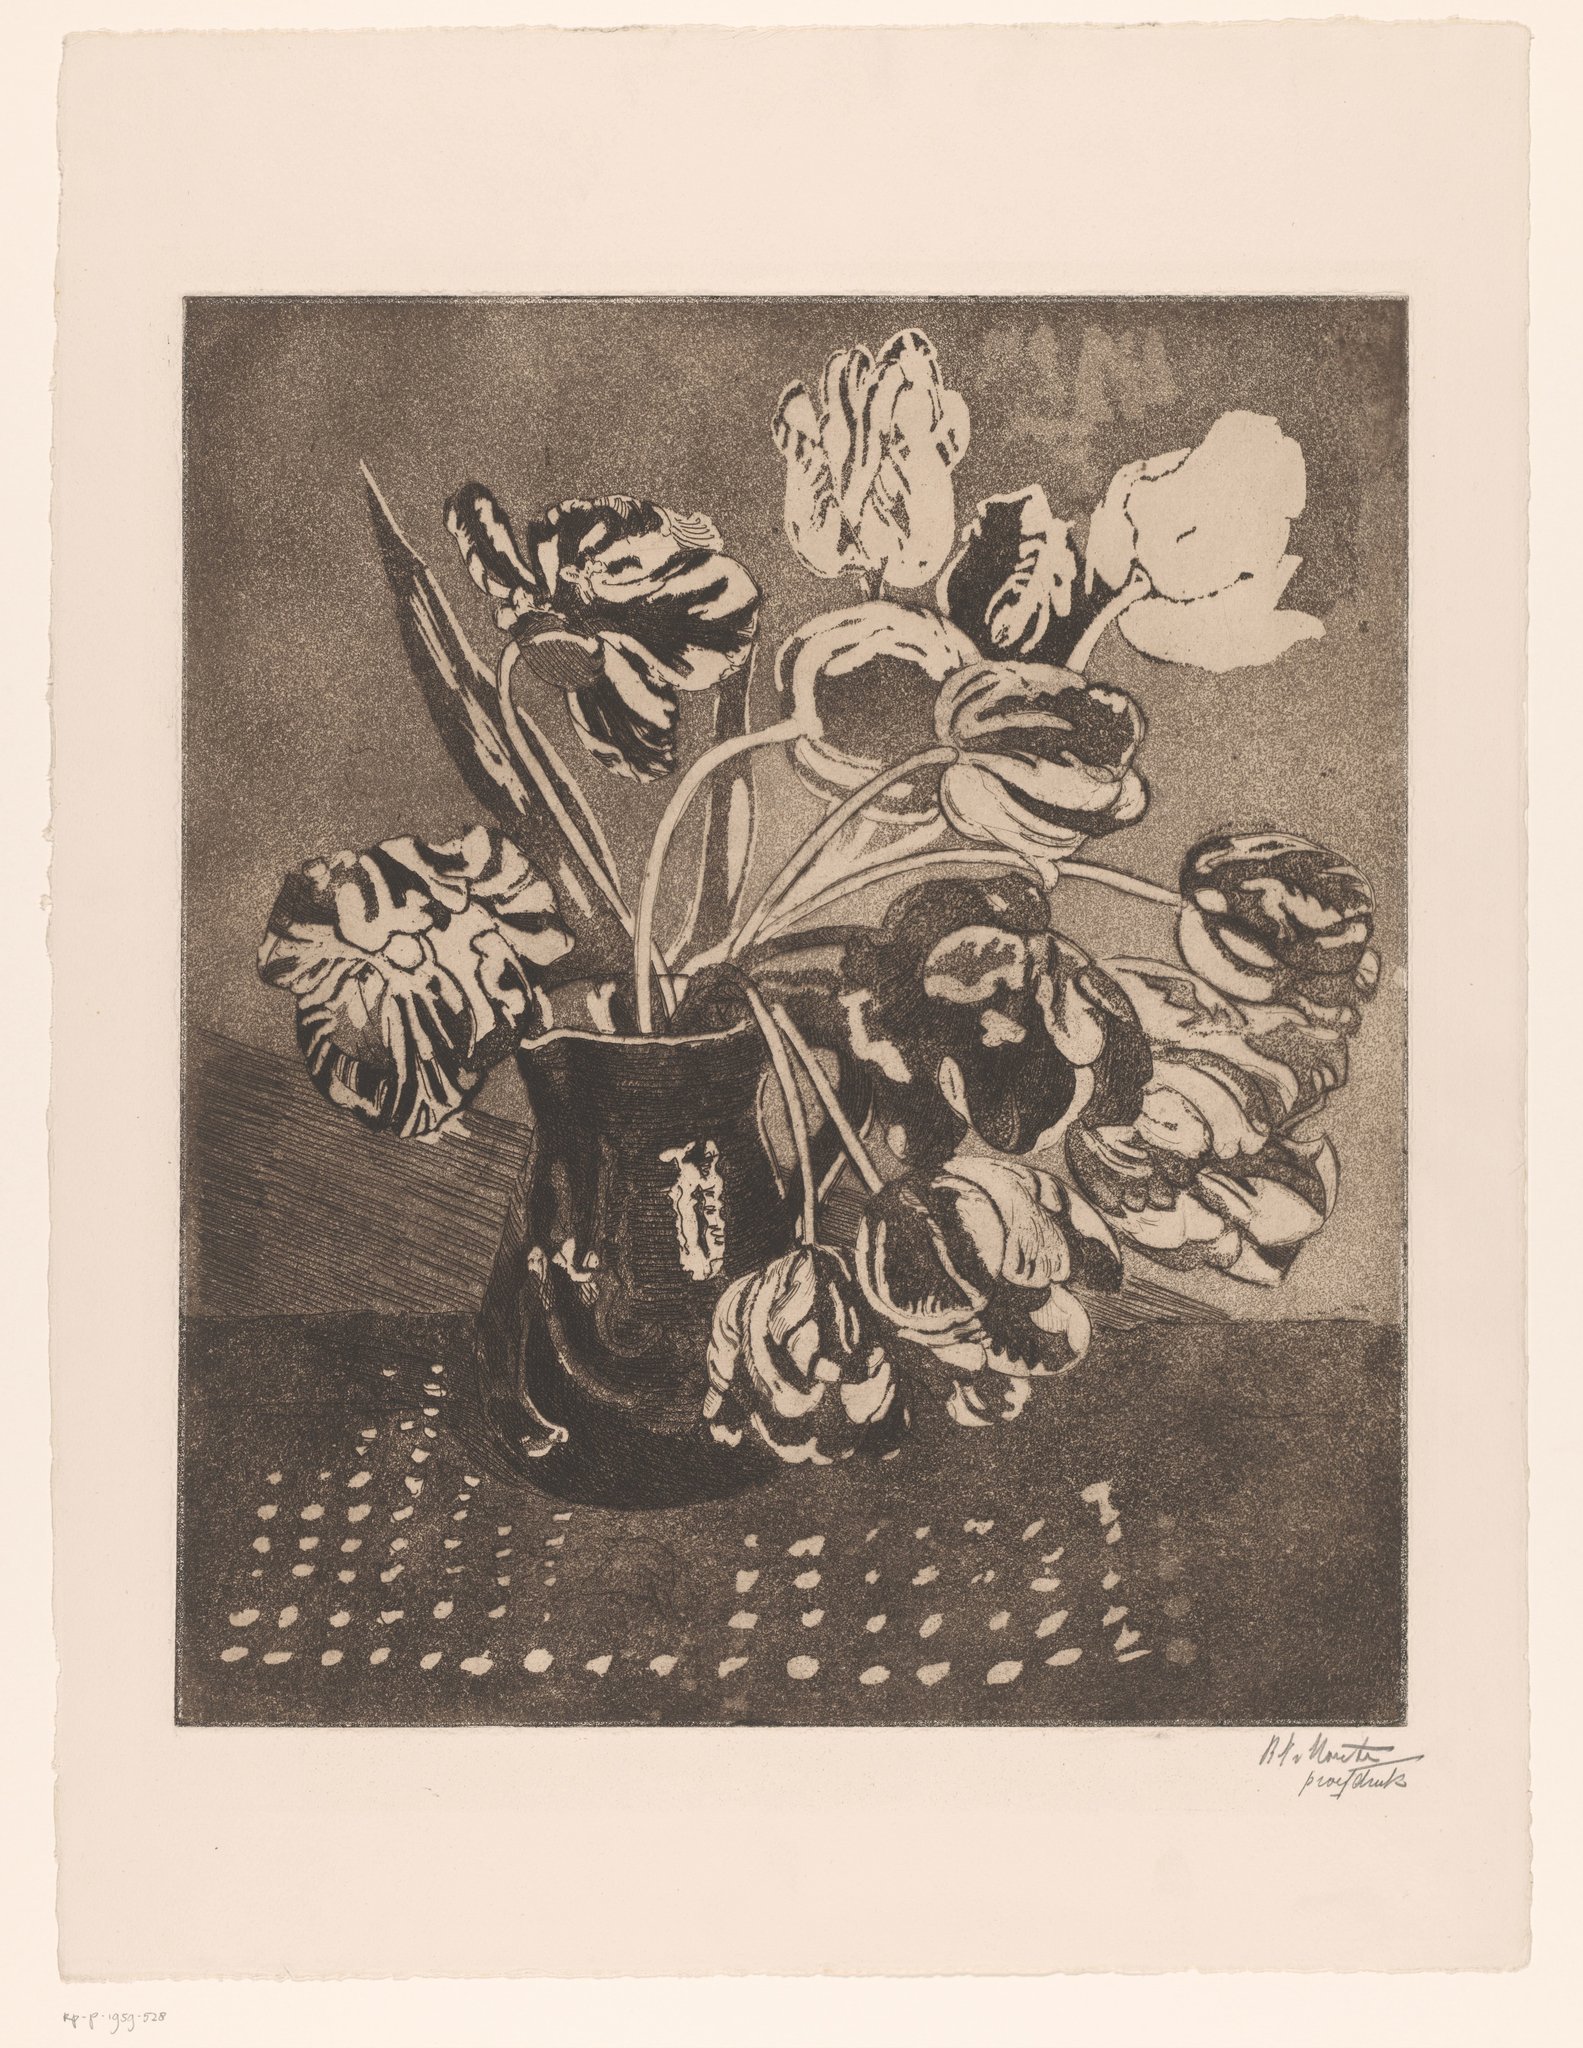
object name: print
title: Tulpen in een kan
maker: barbara elisabeth van houten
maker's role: draughtsman, print maker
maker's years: 1862-1950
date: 1872-1950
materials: paper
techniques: aquatint, etching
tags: flowers: tulip, flowers in a vase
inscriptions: collector's mark: Lugt 2228